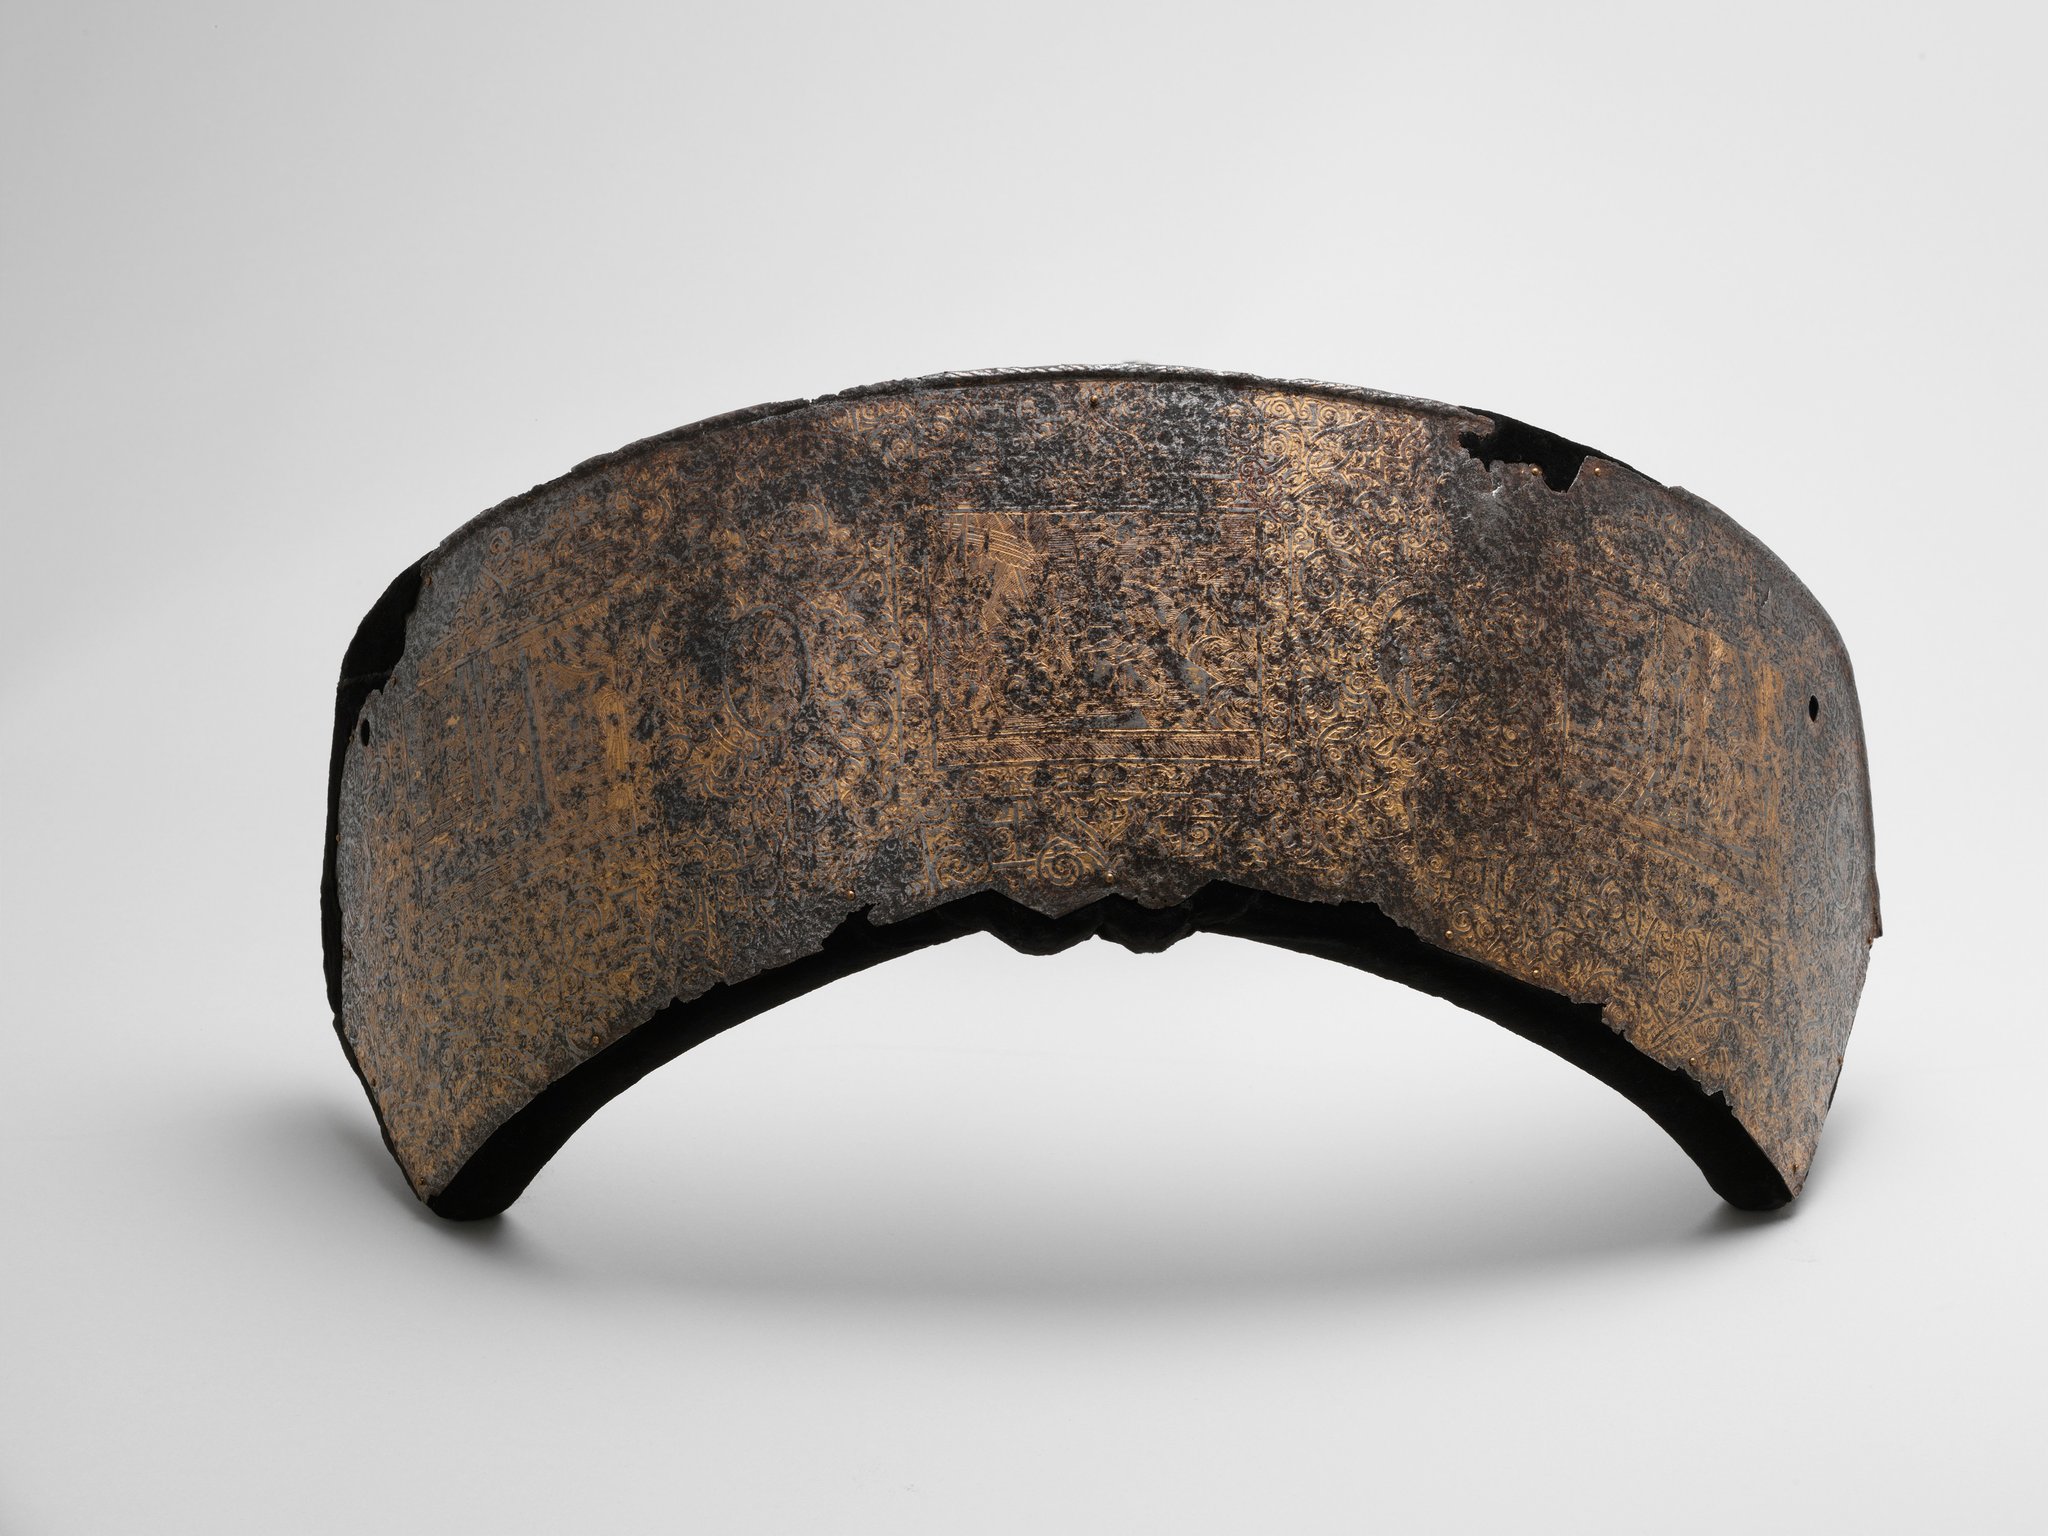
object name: cantle plate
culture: german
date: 1565-1575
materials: gold, steel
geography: germany